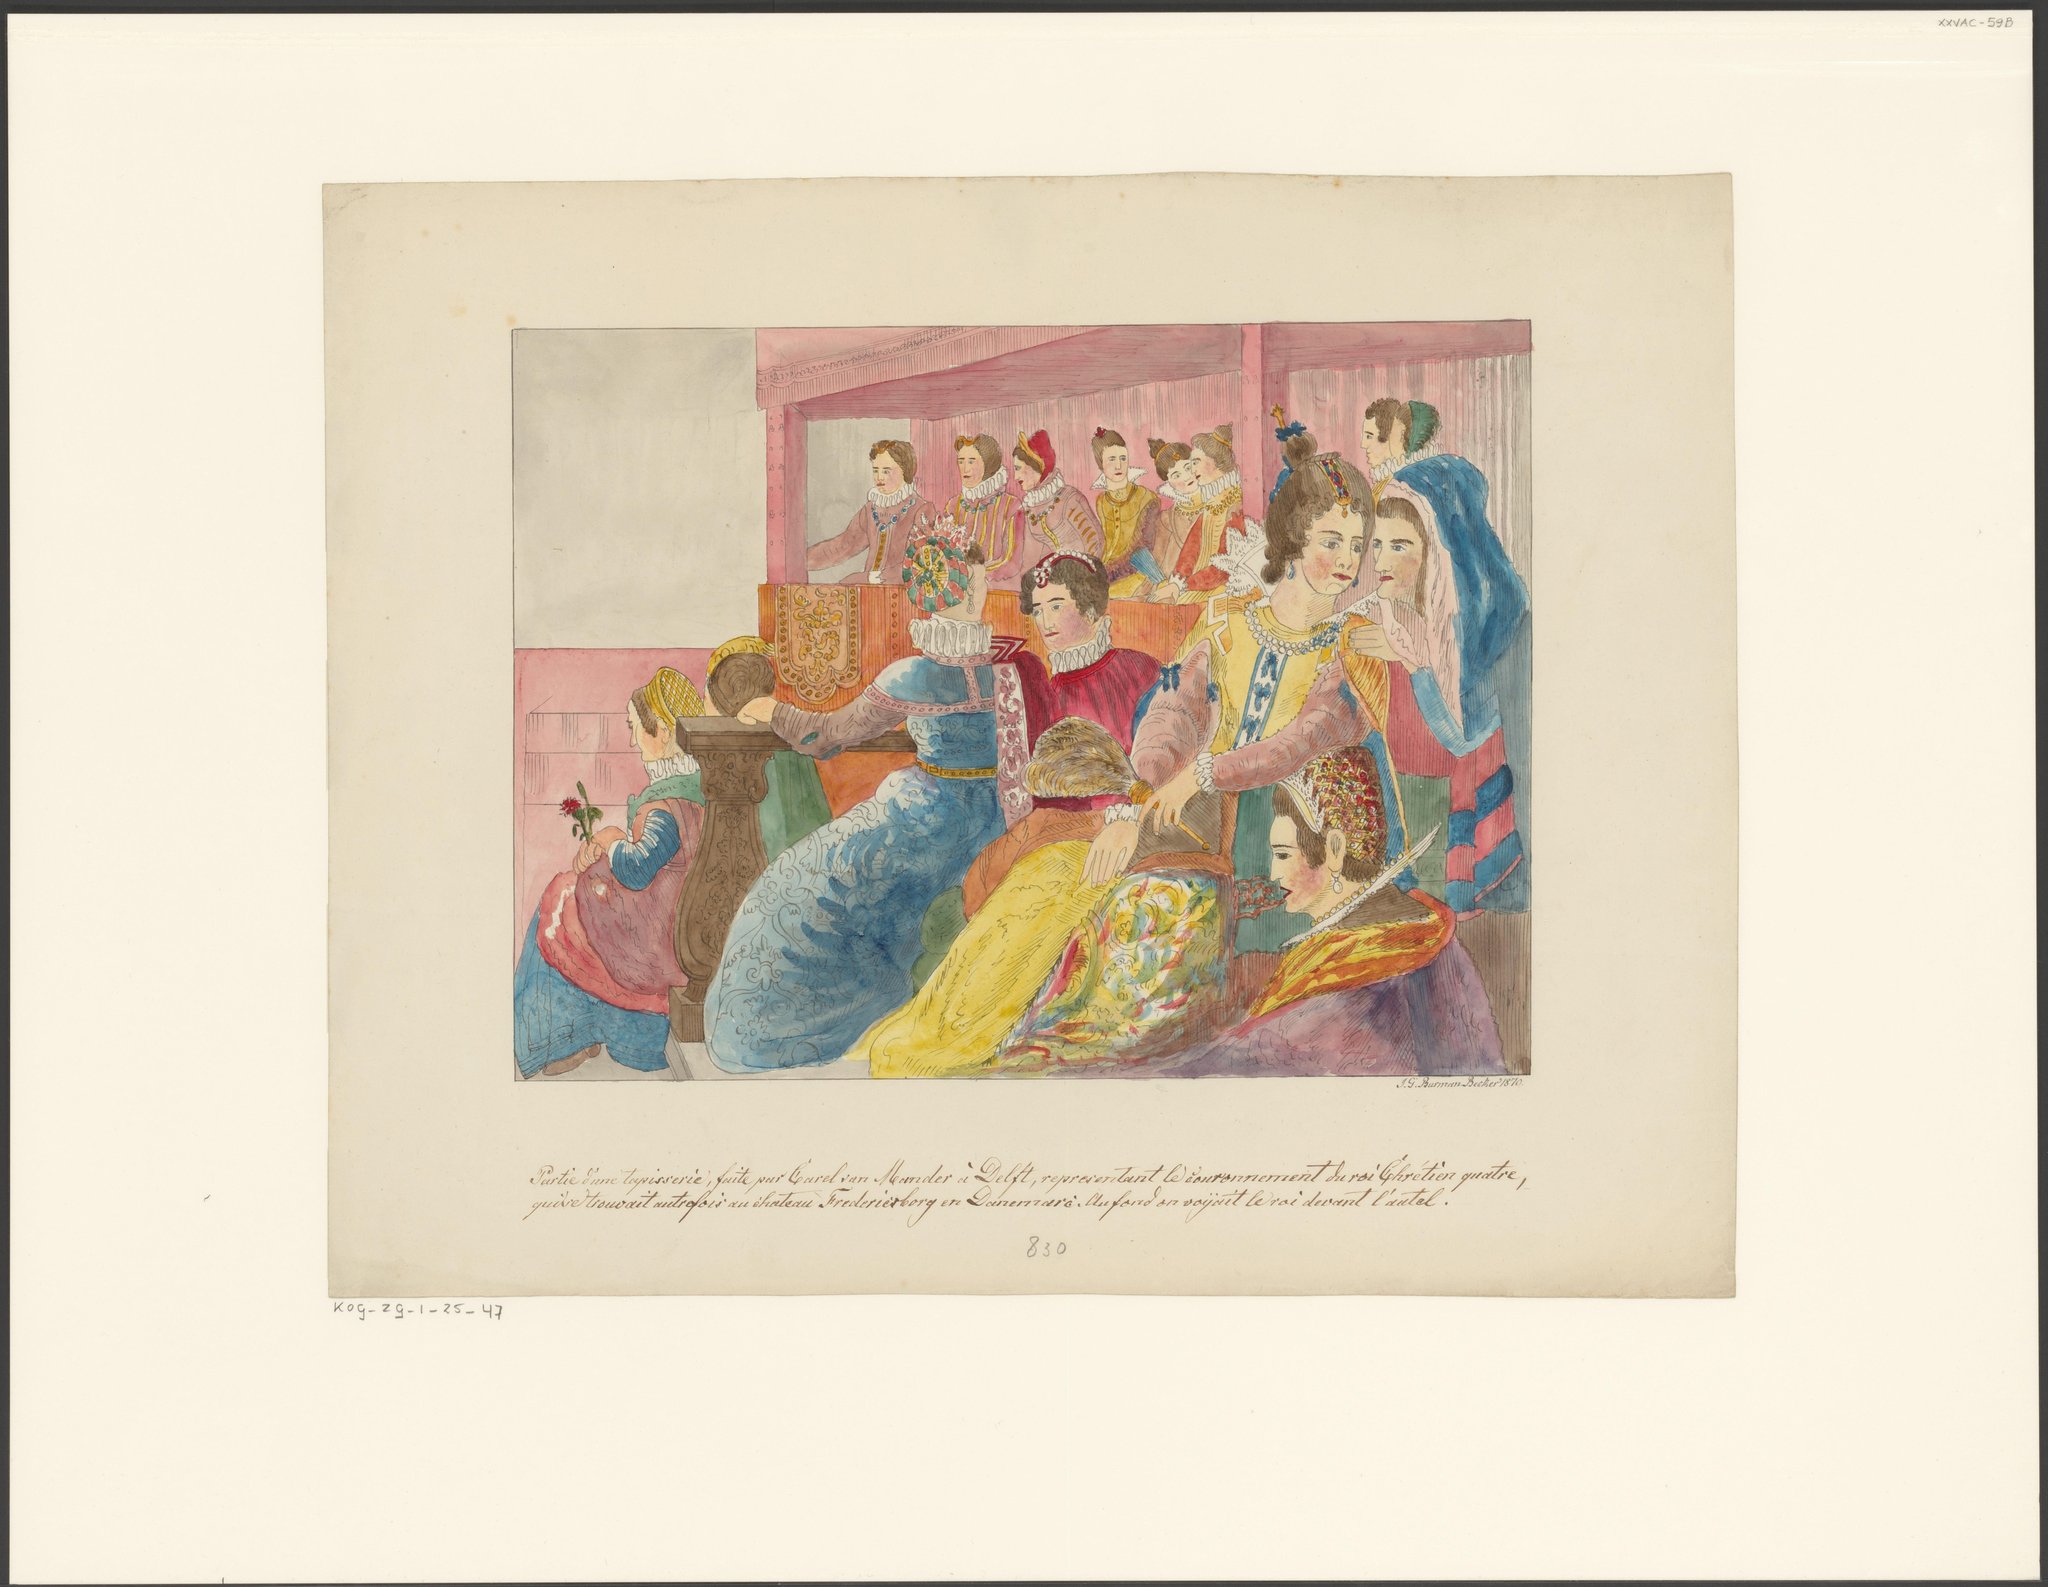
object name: drawing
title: Hof van Christiaan IV, koning van Denemarken en Noorwegen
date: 1870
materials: ink, paper, watercolor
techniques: brush, pen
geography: delft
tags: copenhagen (city), christiaan iv (koning van denemarken en noorwegen), playing-cards, dog, delft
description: Naar een tapijt uit Frederiksborg. Onderwerpsrubrieken binnen de Atlas Zeden en Gewoonten: Zeden en Gewoonten in Engeren Zin, De Woning, Binnenhuizen, Wandversiering.